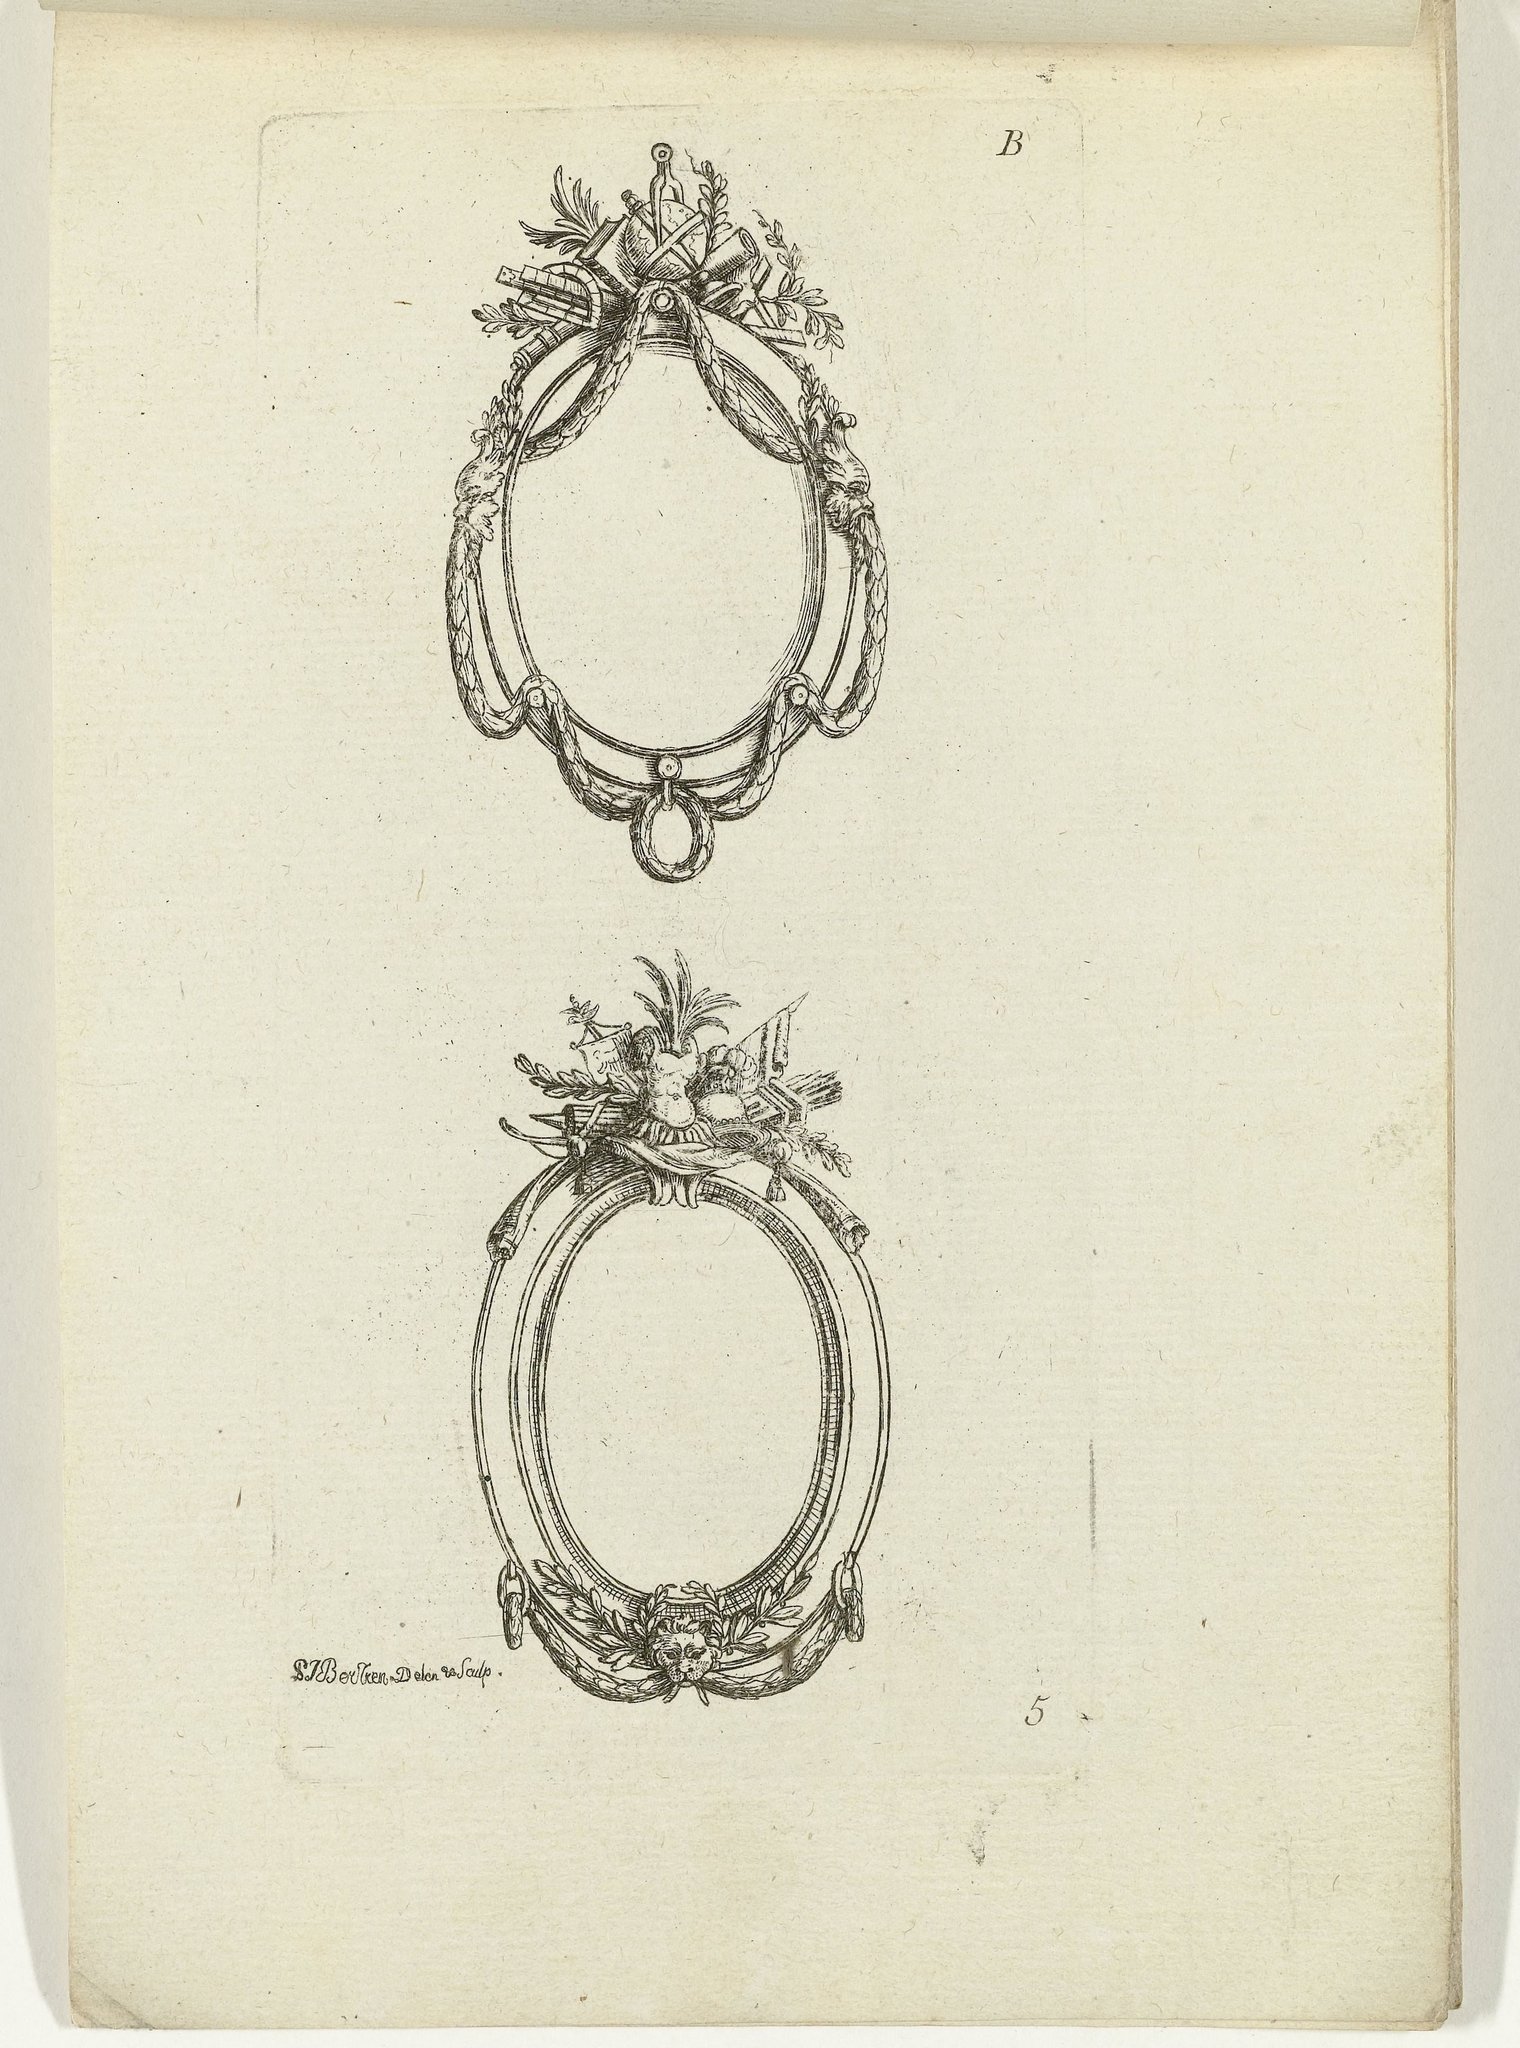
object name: ornament print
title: Ornamentele ontwerpen voor sieraden en rijtuigen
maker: théodore bertren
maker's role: print maker, publisher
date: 1768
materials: paper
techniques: etching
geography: paris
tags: drawing-instruments, ornament ~ medallion, armour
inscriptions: collector's mark: Lugt 2228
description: De bovenste omlijsting is versierd met wetenschappelijke instrumenten en de onderste met wapenrusting. Ornamentprent uit serie B.